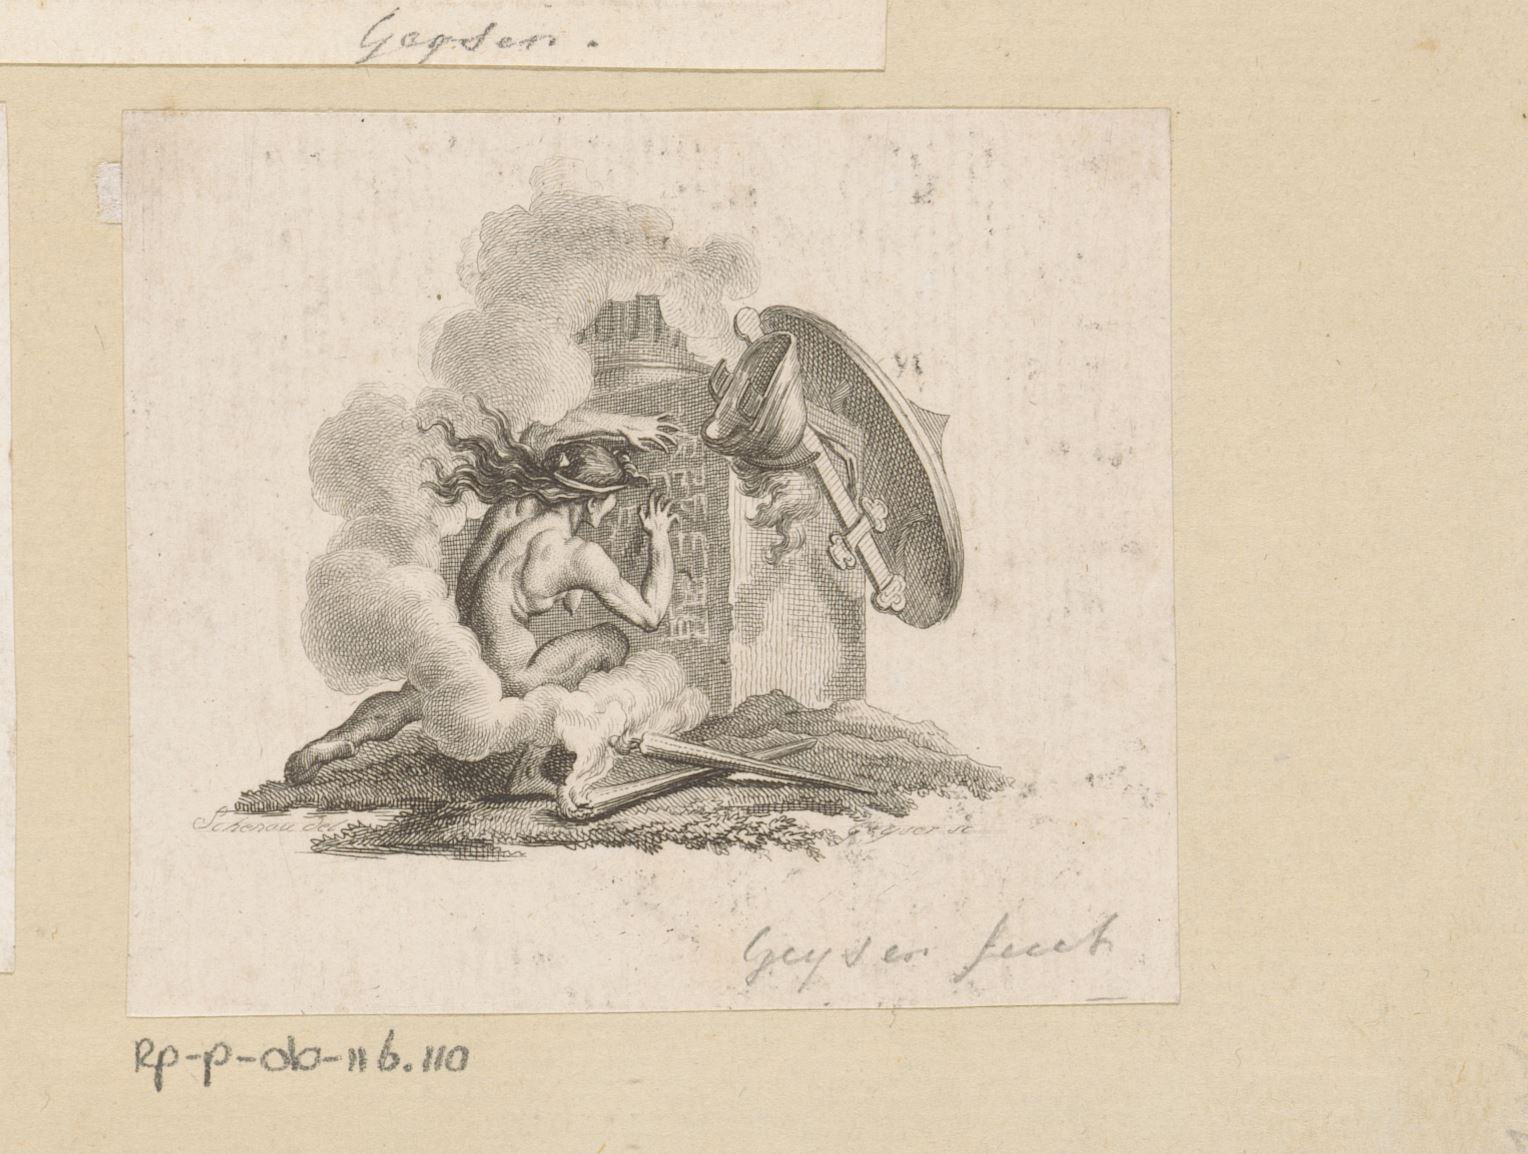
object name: print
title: Mythologische vrouw probeert een inscriptie te lezen na zich van haar wapenuitrusting te hebben ontdaan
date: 1752-1803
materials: paper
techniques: etching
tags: inscription, armour, base (~ column, pillar), bellona (enyo)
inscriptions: collector's mark: Lugt 2228